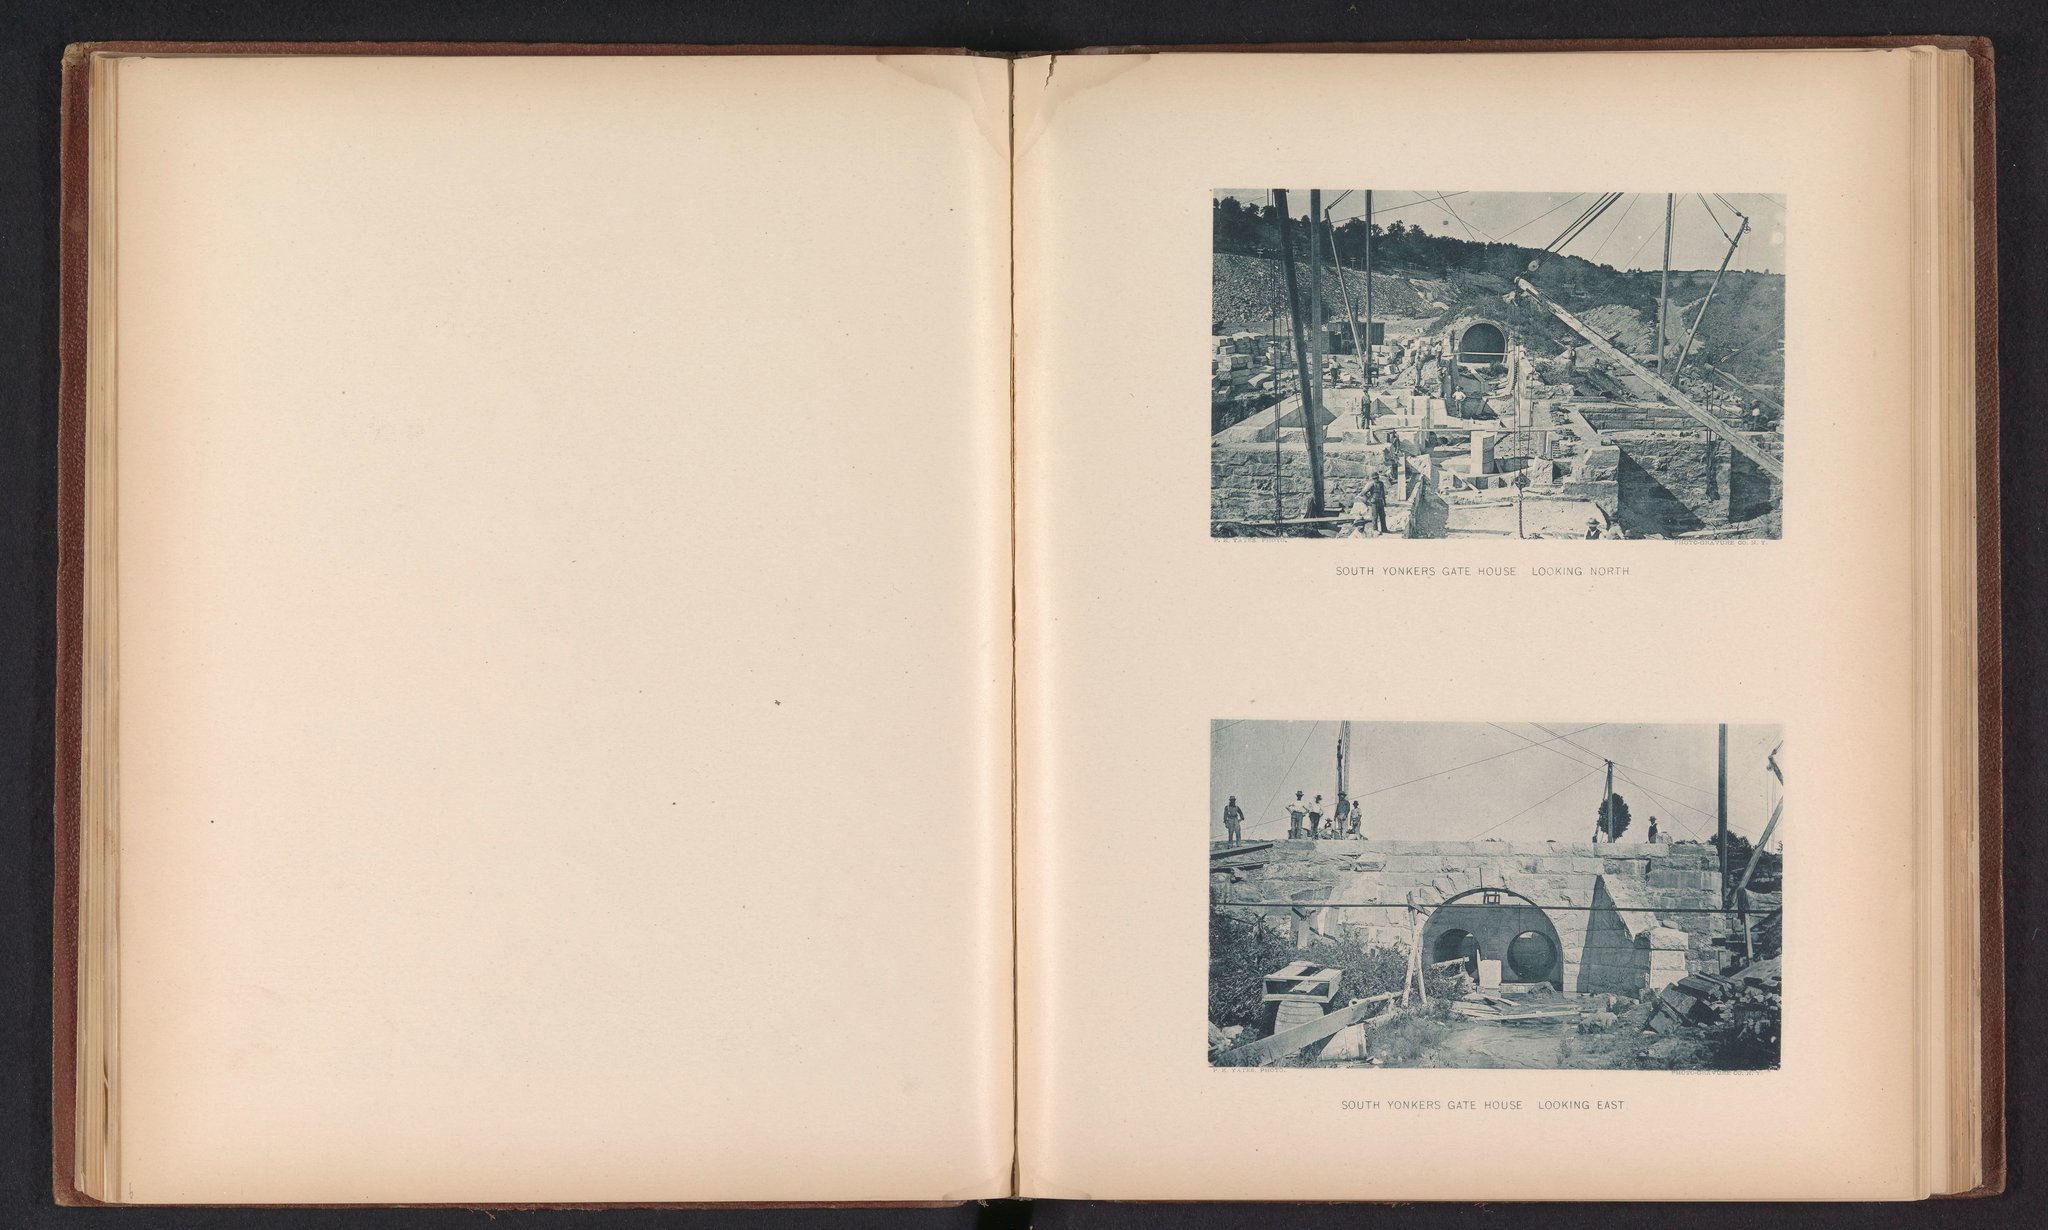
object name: page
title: South Yonkers Gate House looking north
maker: preston k. yates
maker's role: engineer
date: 1883-1887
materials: paper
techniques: photograph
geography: new york city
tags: working class, labourers, gate, entrance, building-site